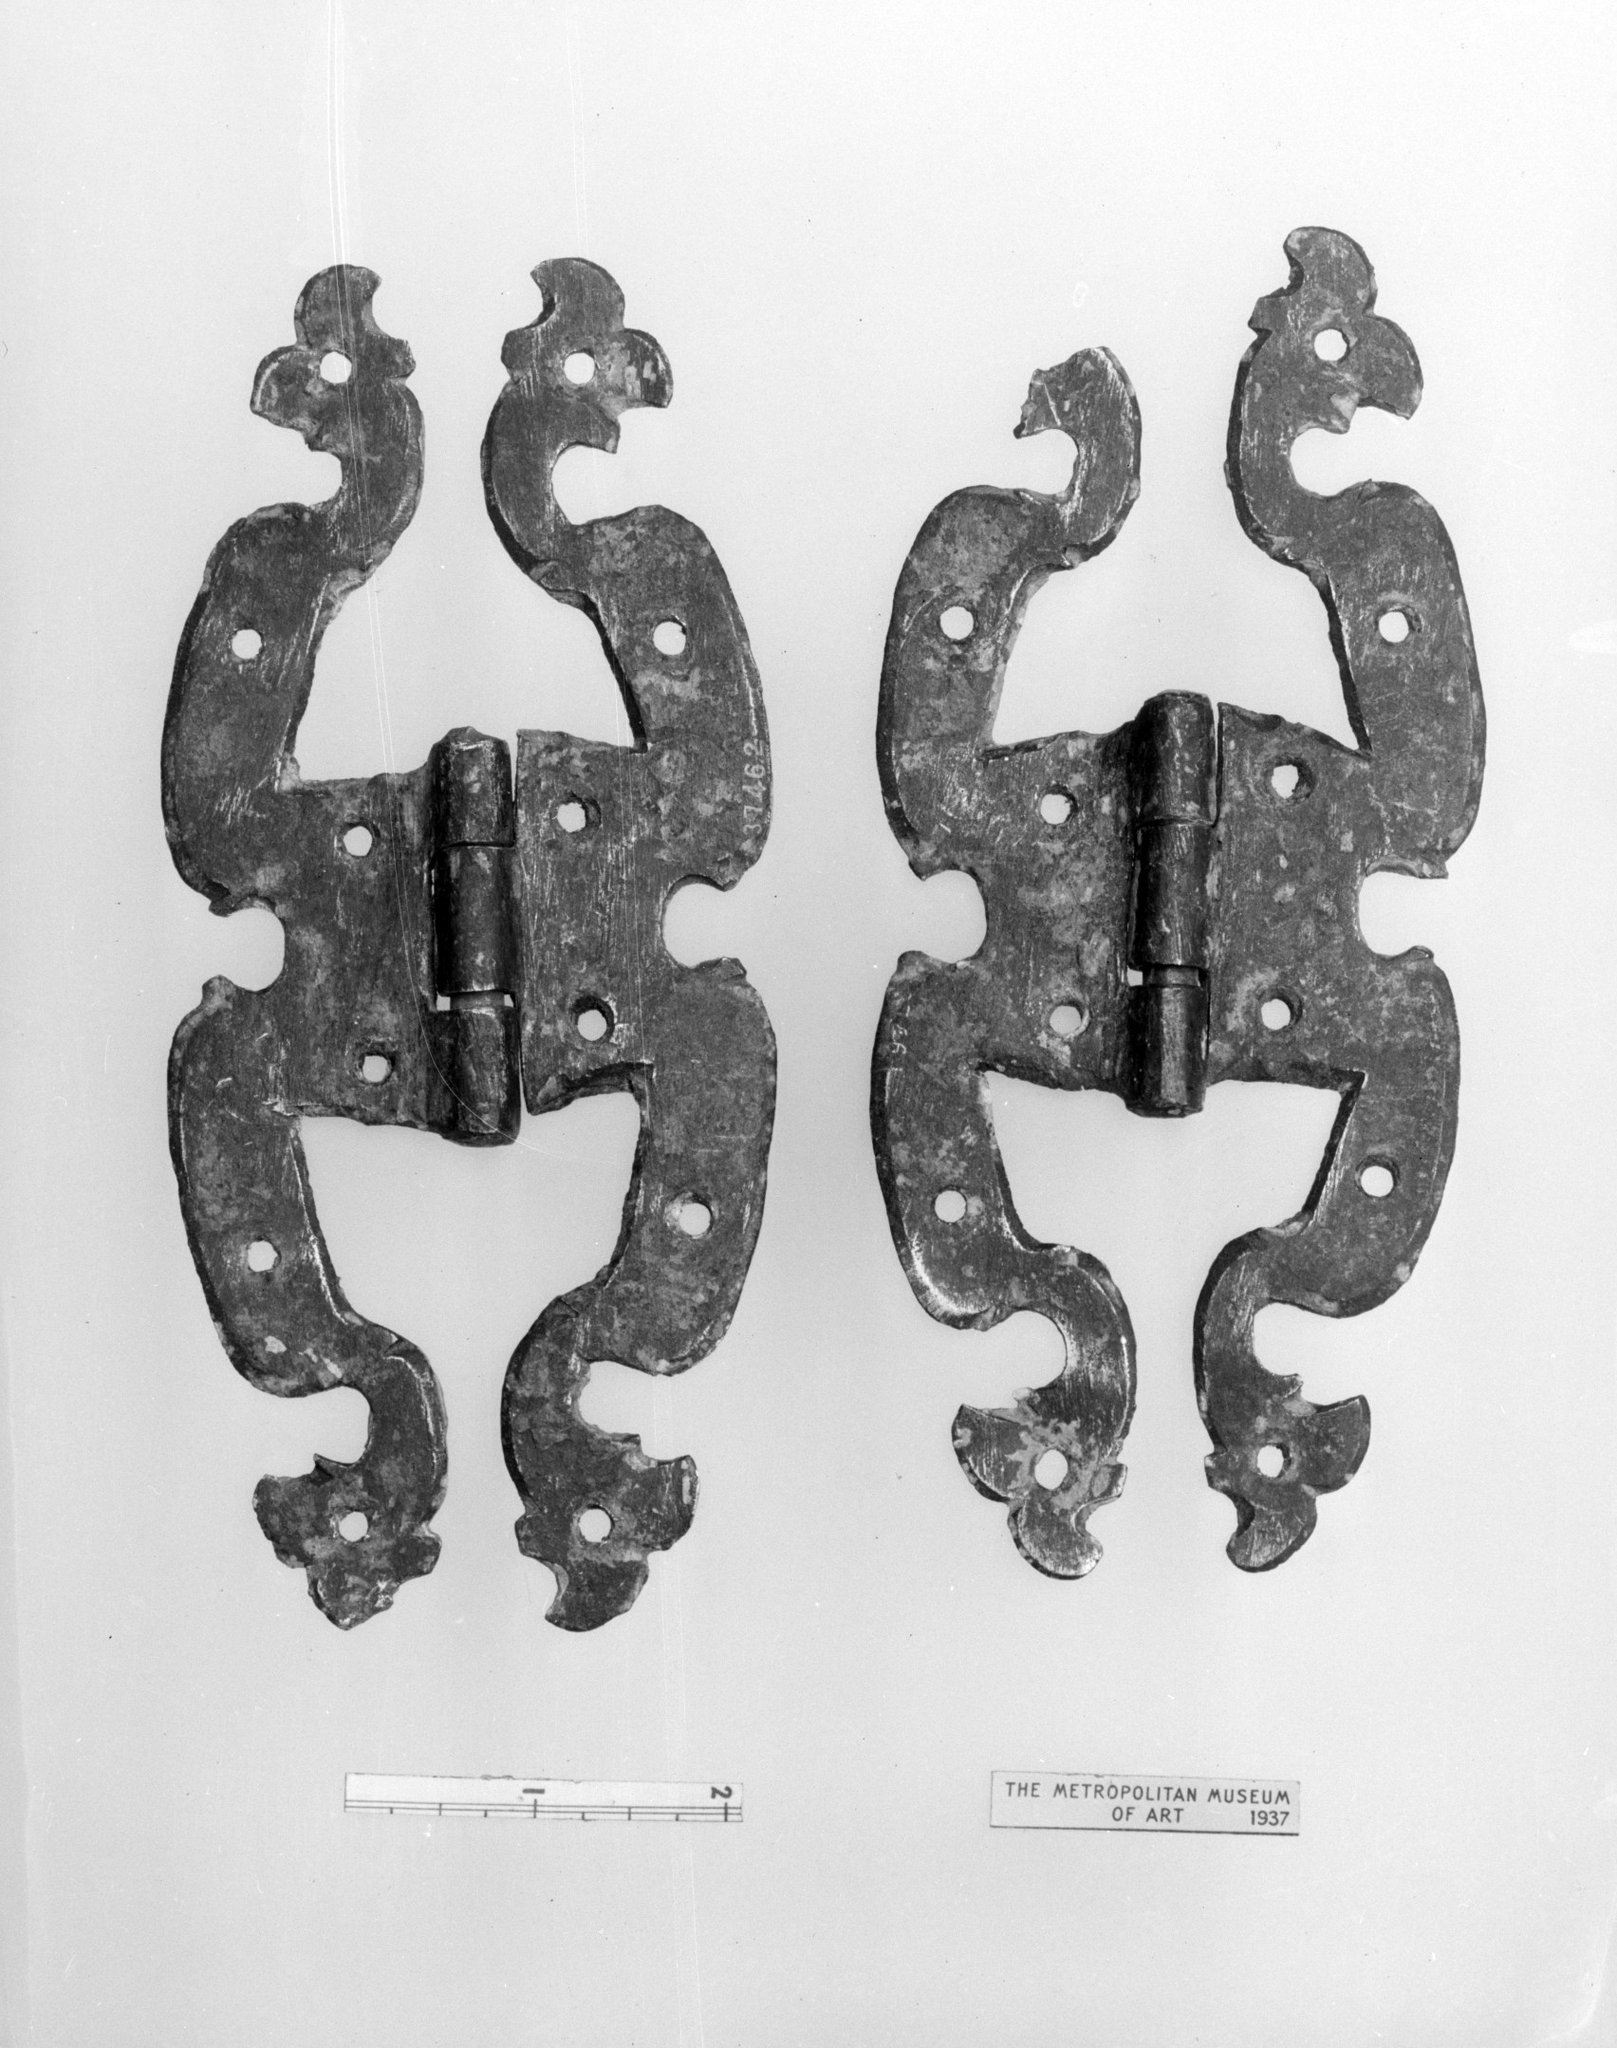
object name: hinge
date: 1630-1670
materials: iron